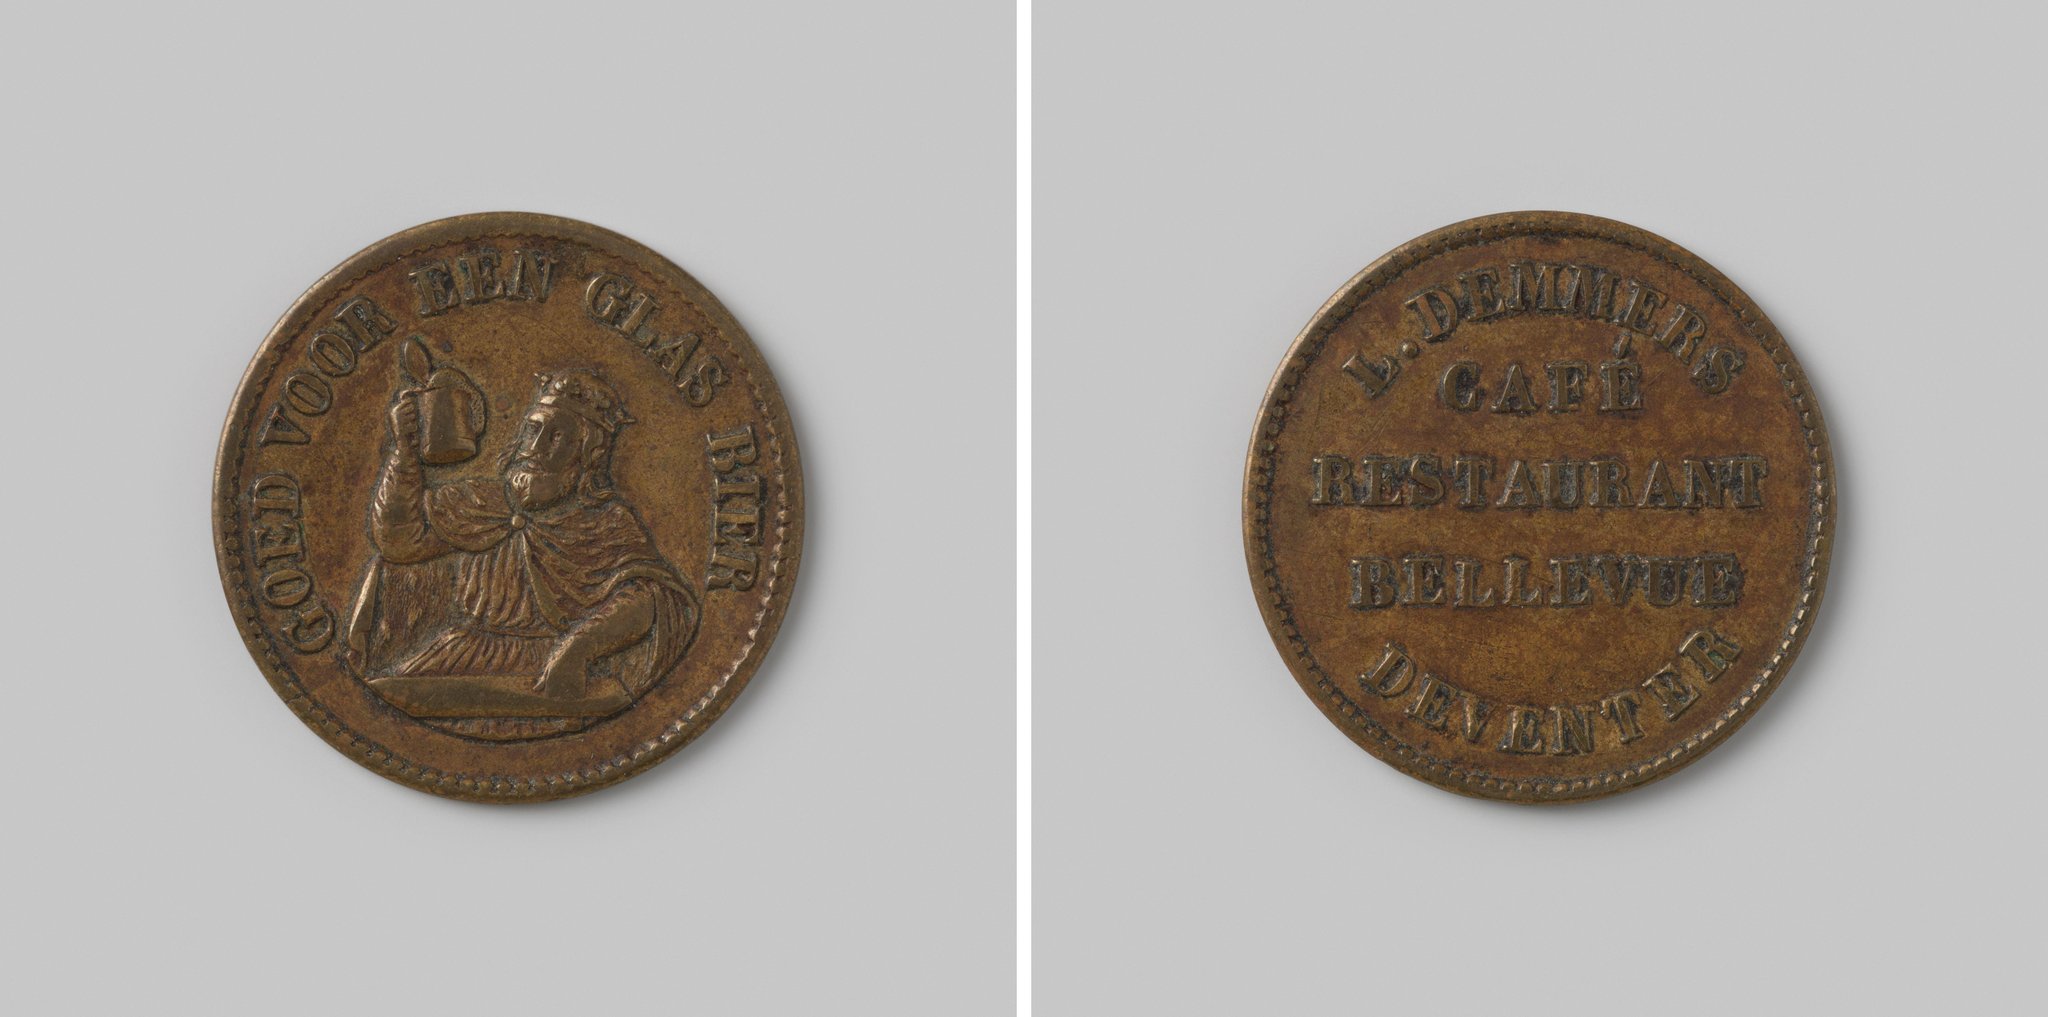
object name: history medal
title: Bierpenning van Cafe Restaurant Bellevue van L. Demmers te Deventer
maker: Anonymous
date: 1850-1900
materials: brass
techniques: striking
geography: netherlands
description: Messing penning, op de voorzijde Gambrinus in koningsgewaad een pul bier heffend, met omschrift, op de keerzijde vijf regels tekst.